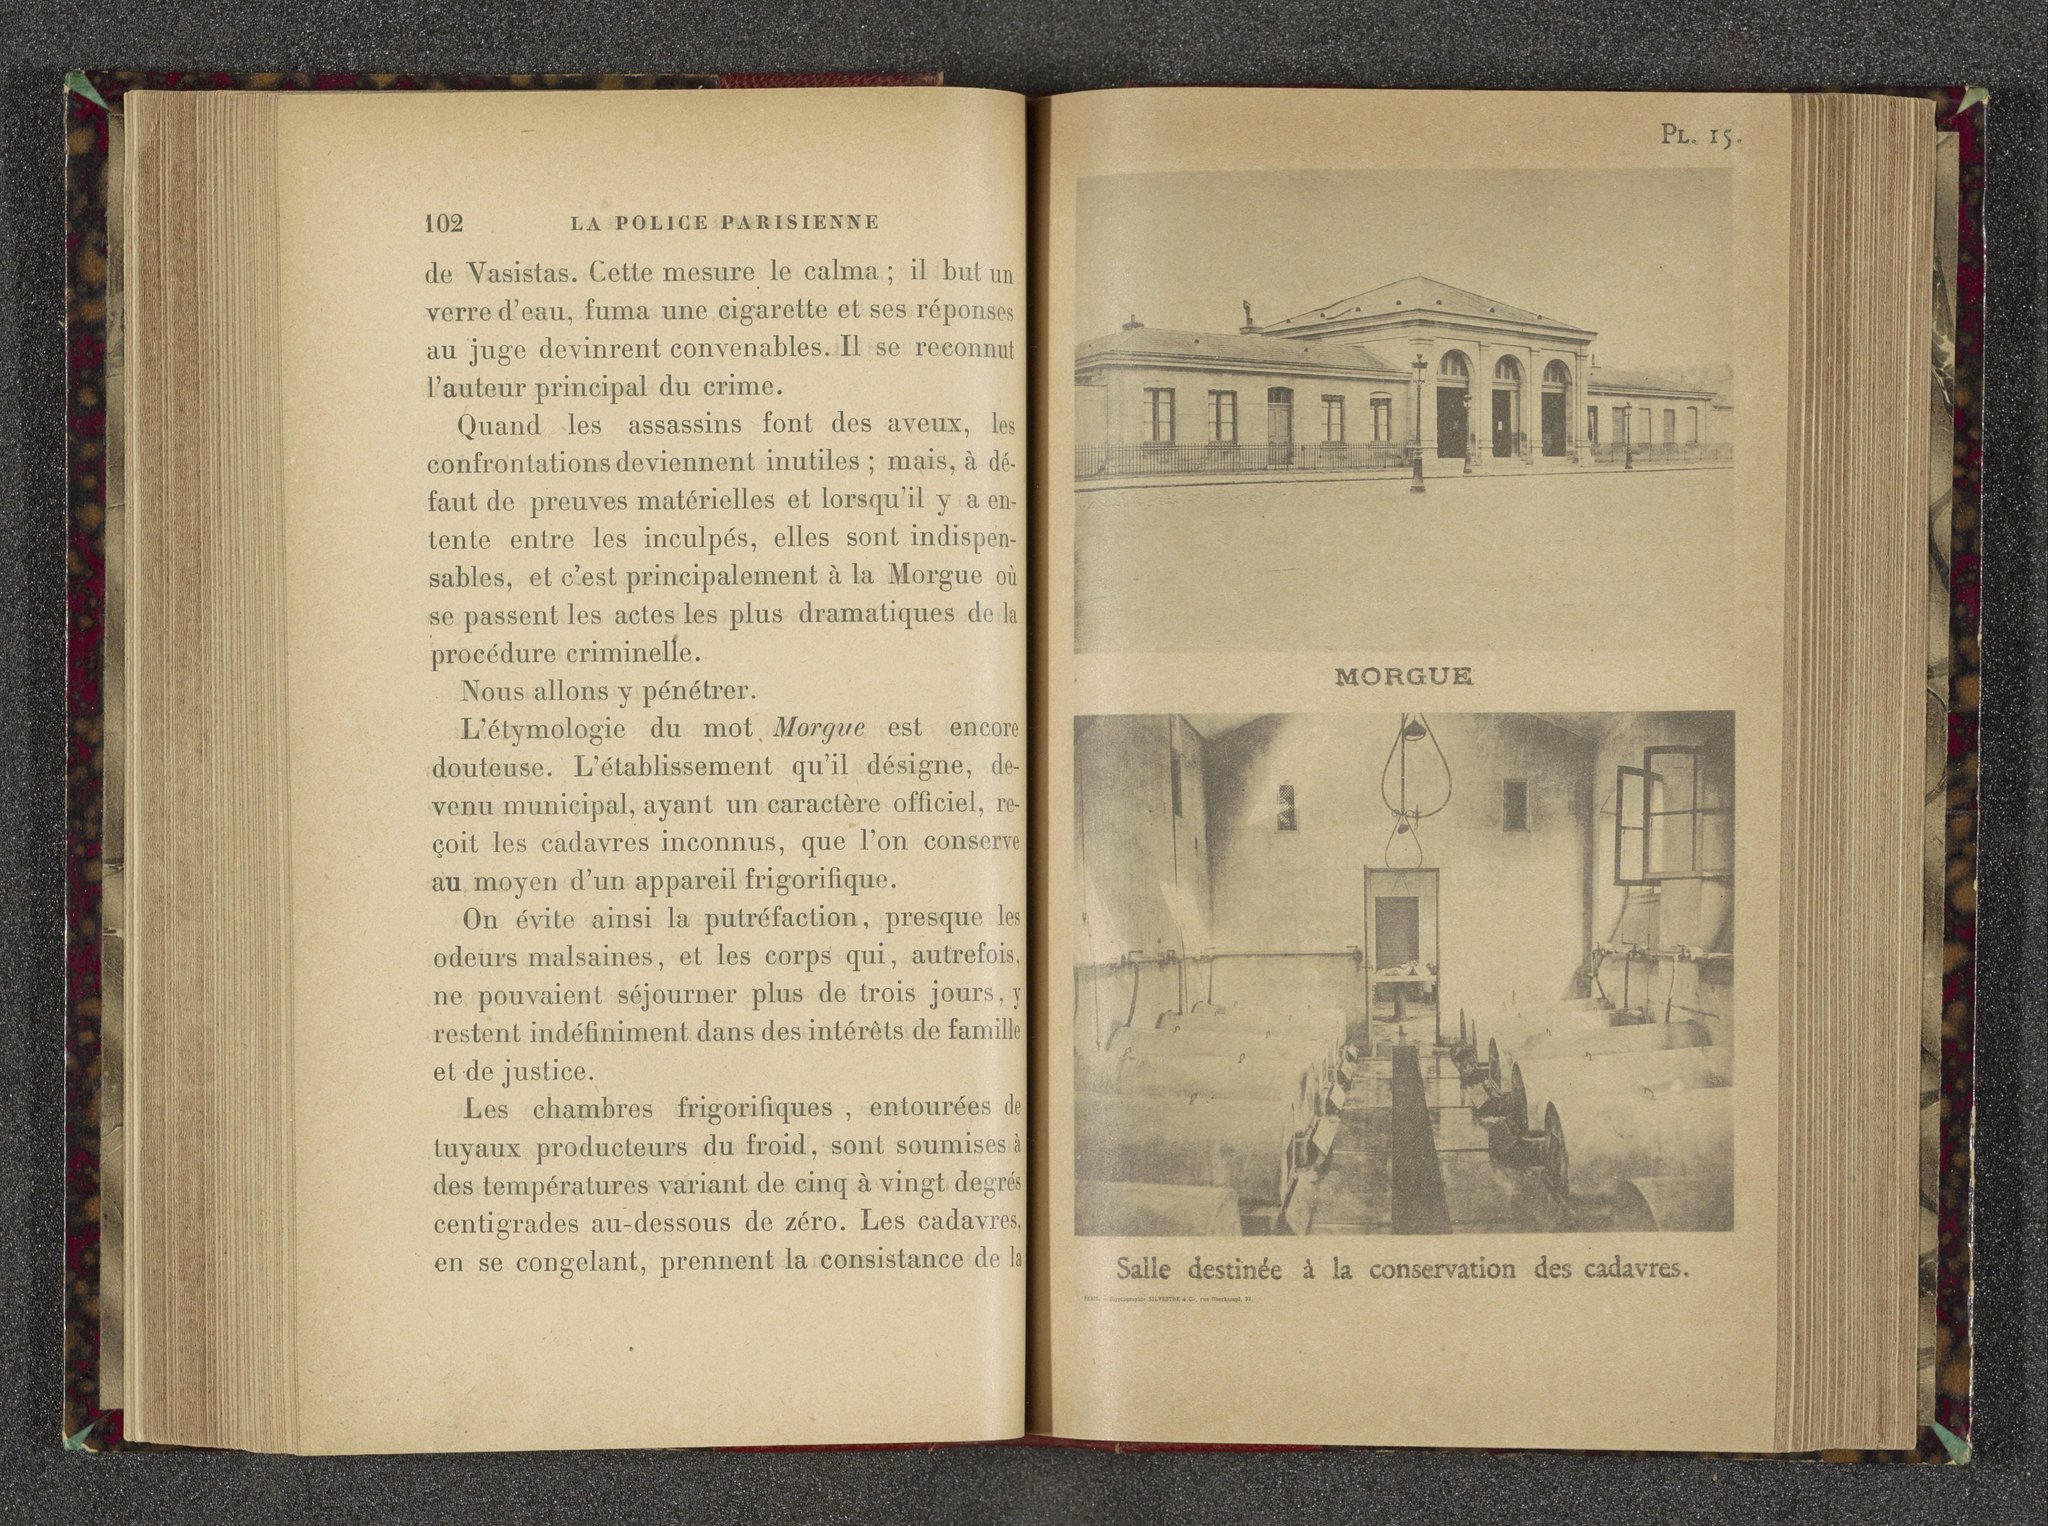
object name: photomechanical print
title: Morgue Salle destinée à la conservation des cadavres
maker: Anonymous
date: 1880-1890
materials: paper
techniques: photograph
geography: paris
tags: mortuary specialists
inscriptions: number: ‘Pl. 15.’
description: Boven: exterieur van een lijkenhuis, onder: zaal voor het behoud van de lijken.